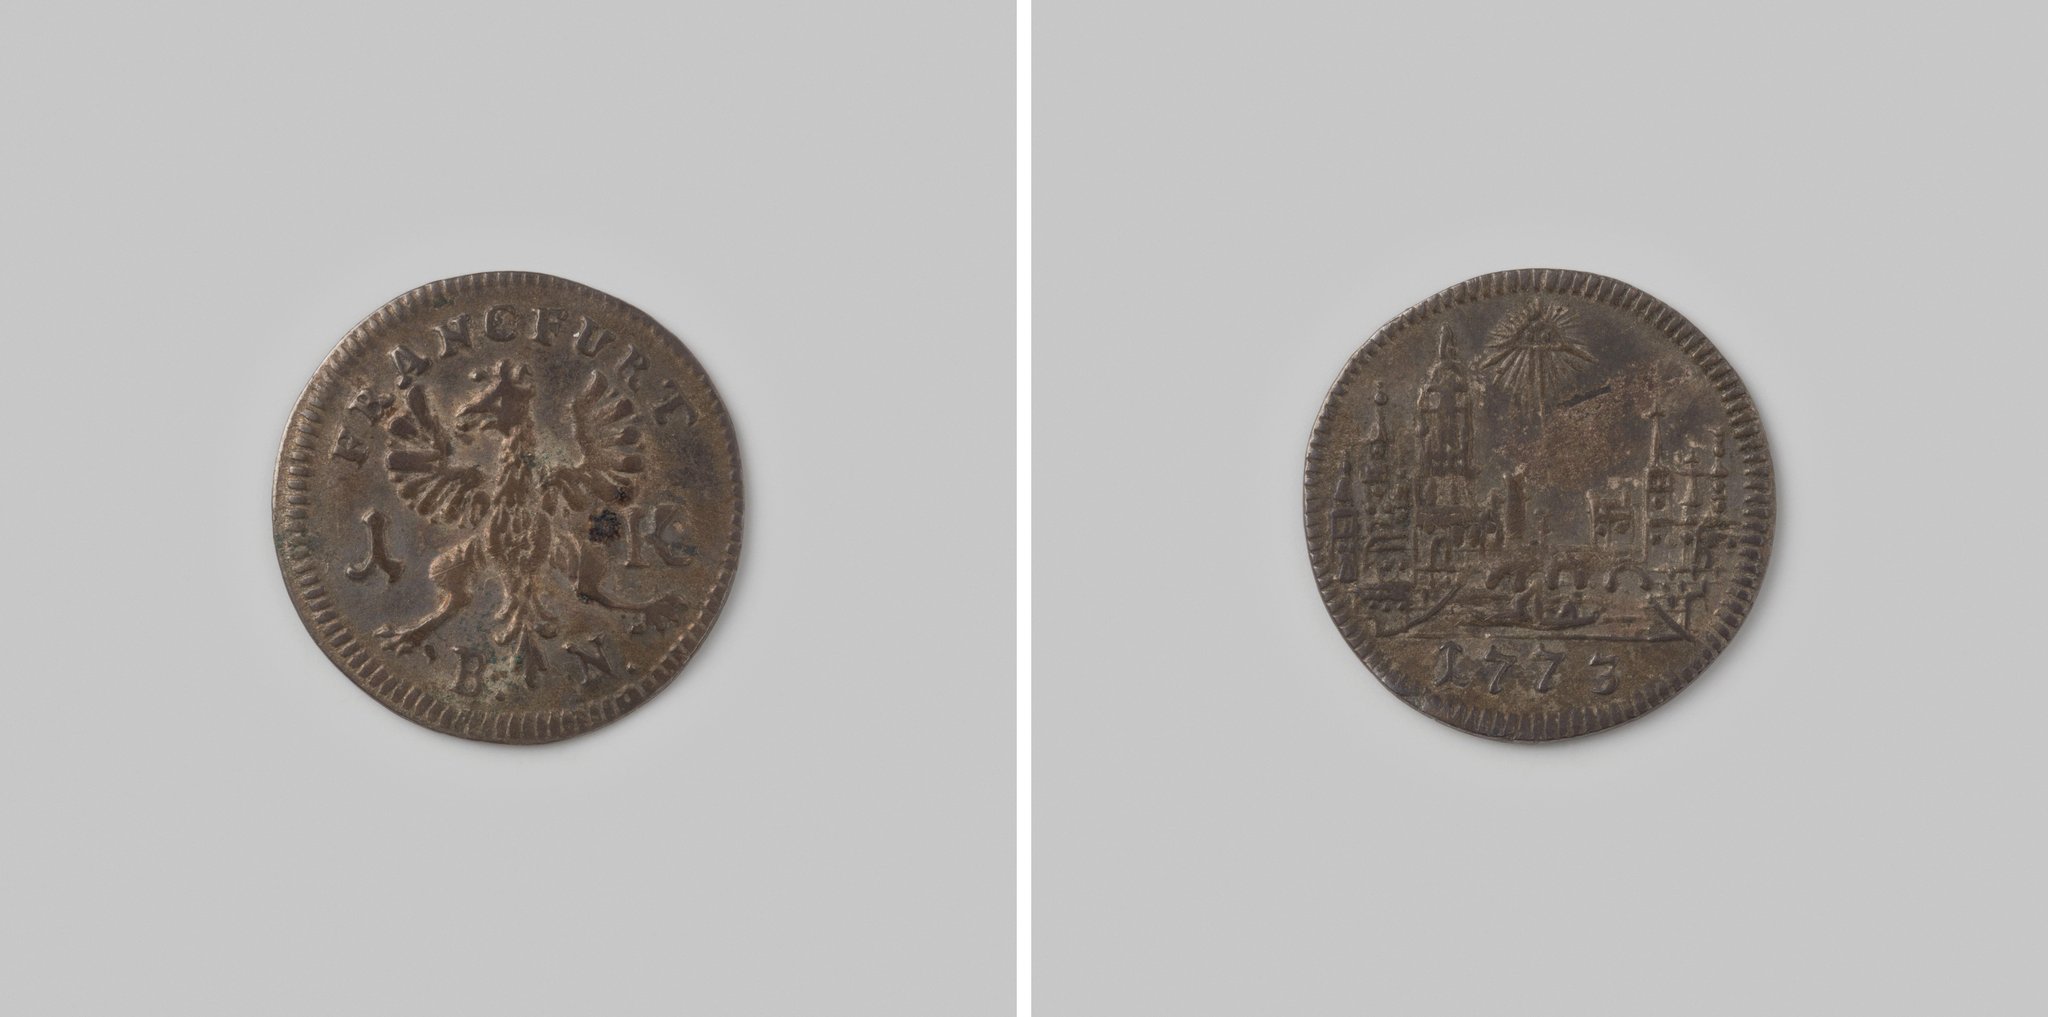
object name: coin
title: Vrije rijksstad Frankfurt am Main, kreuzer, 1773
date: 1773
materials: silver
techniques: striking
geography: frankfurt am main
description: Zilveren munt. Voorzijde: tussen waarde-aanduiding 1 K gekroonde enkekoppige adelaar. Keerzijde: door alziend oog beschenen stadsgezicht met in afsnede jaartal. Gladde rand.